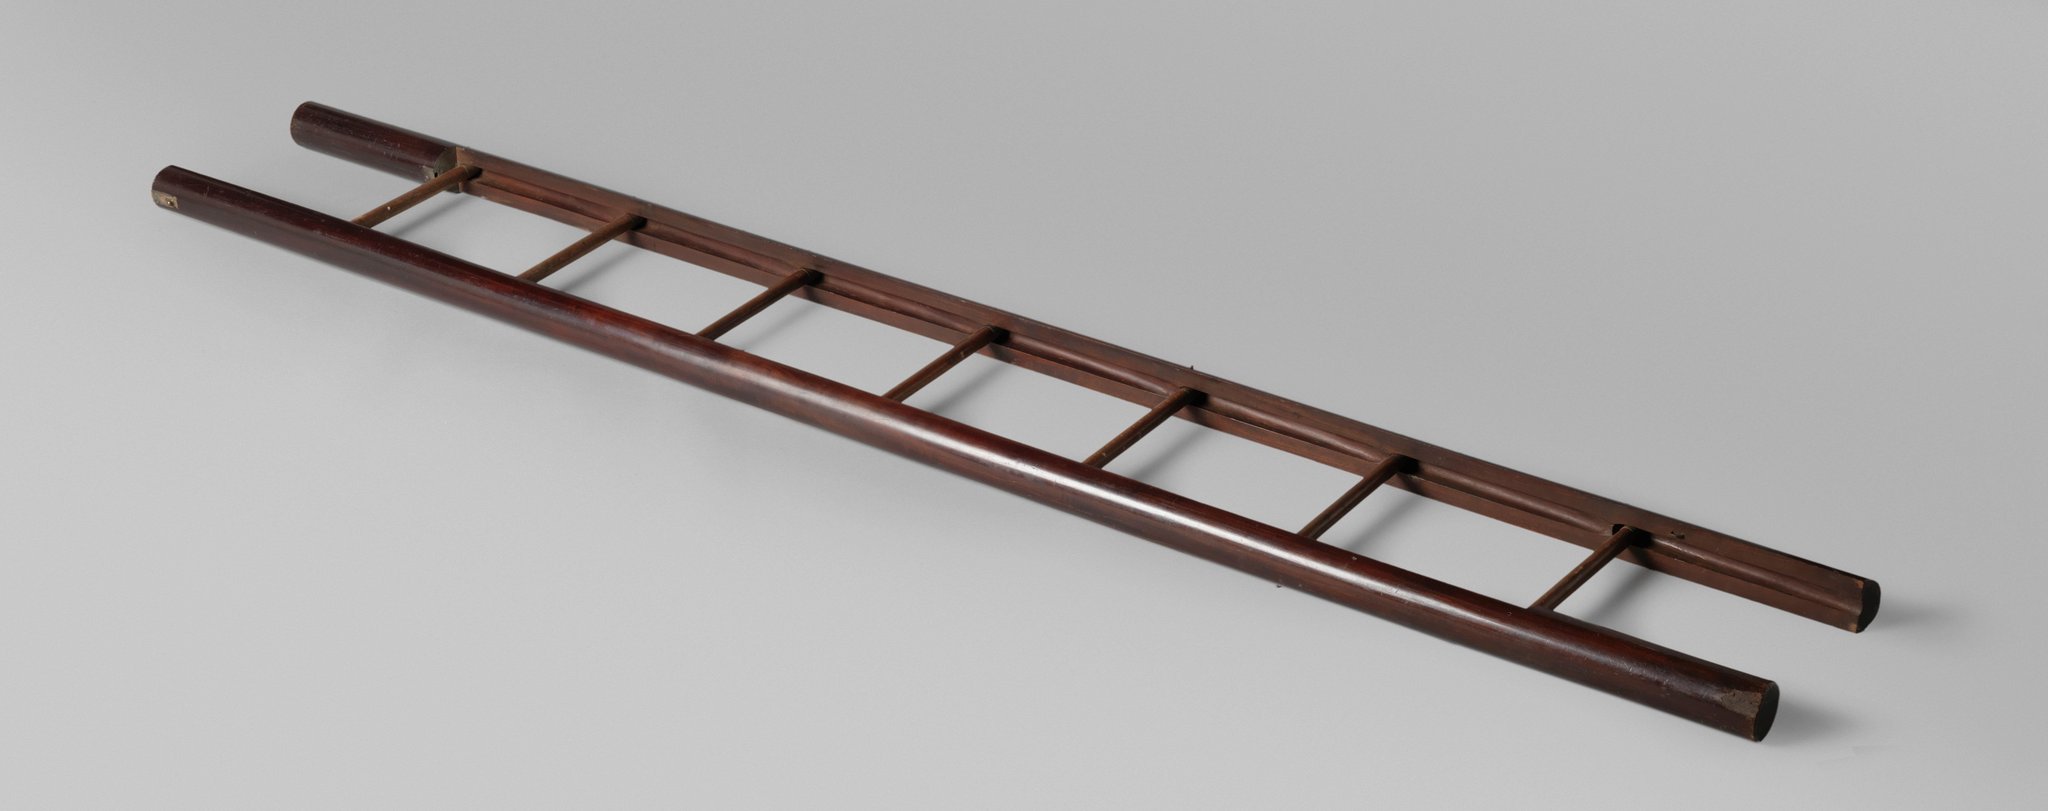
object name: stair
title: Bibliotheektrap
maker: Anonymous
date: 1400-1950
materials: wood